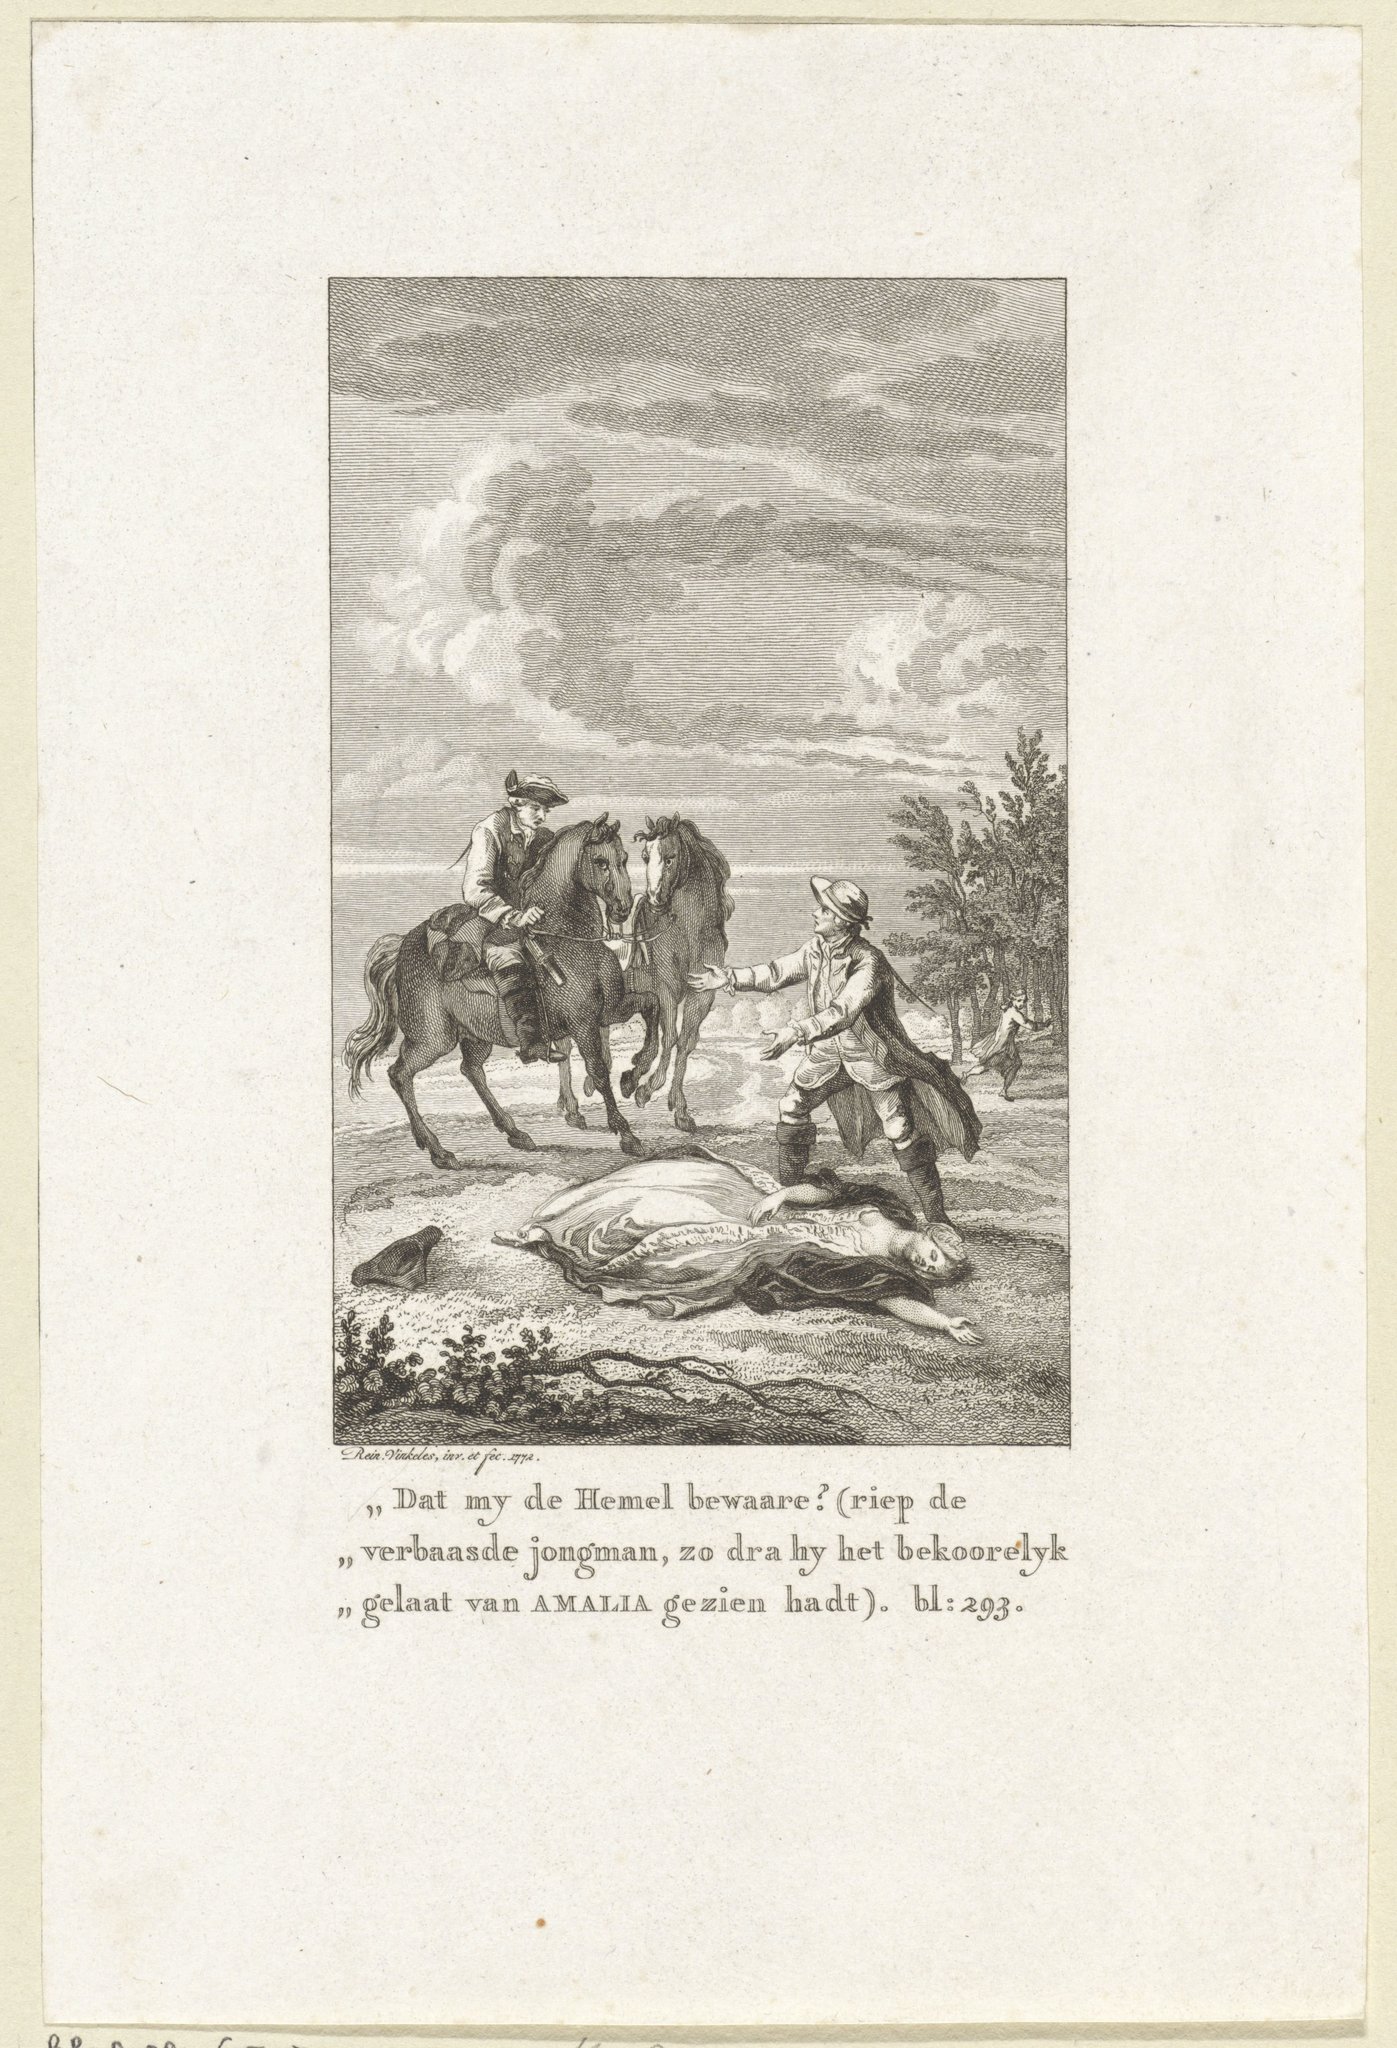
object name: print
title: Ruiter en een man bij een bewusteloze jonge vrouw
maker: reinier vinkeles (i)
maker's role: draughtsman, print maker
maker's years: 1741-1816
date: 1772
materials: paper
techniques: engraving, etching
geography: amsterdam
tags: riding a horse, ass, or mule; rider, horseman, landscapes, apparent death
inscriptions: inscription: ‘"Dat my de Hemel bewaare? (riep de / "verbaasde jongman, zo dra hy het bekoorelyk / "gelaat van Amalia gezien hadt). bl: 293.’, collector's mark: Lugt 240